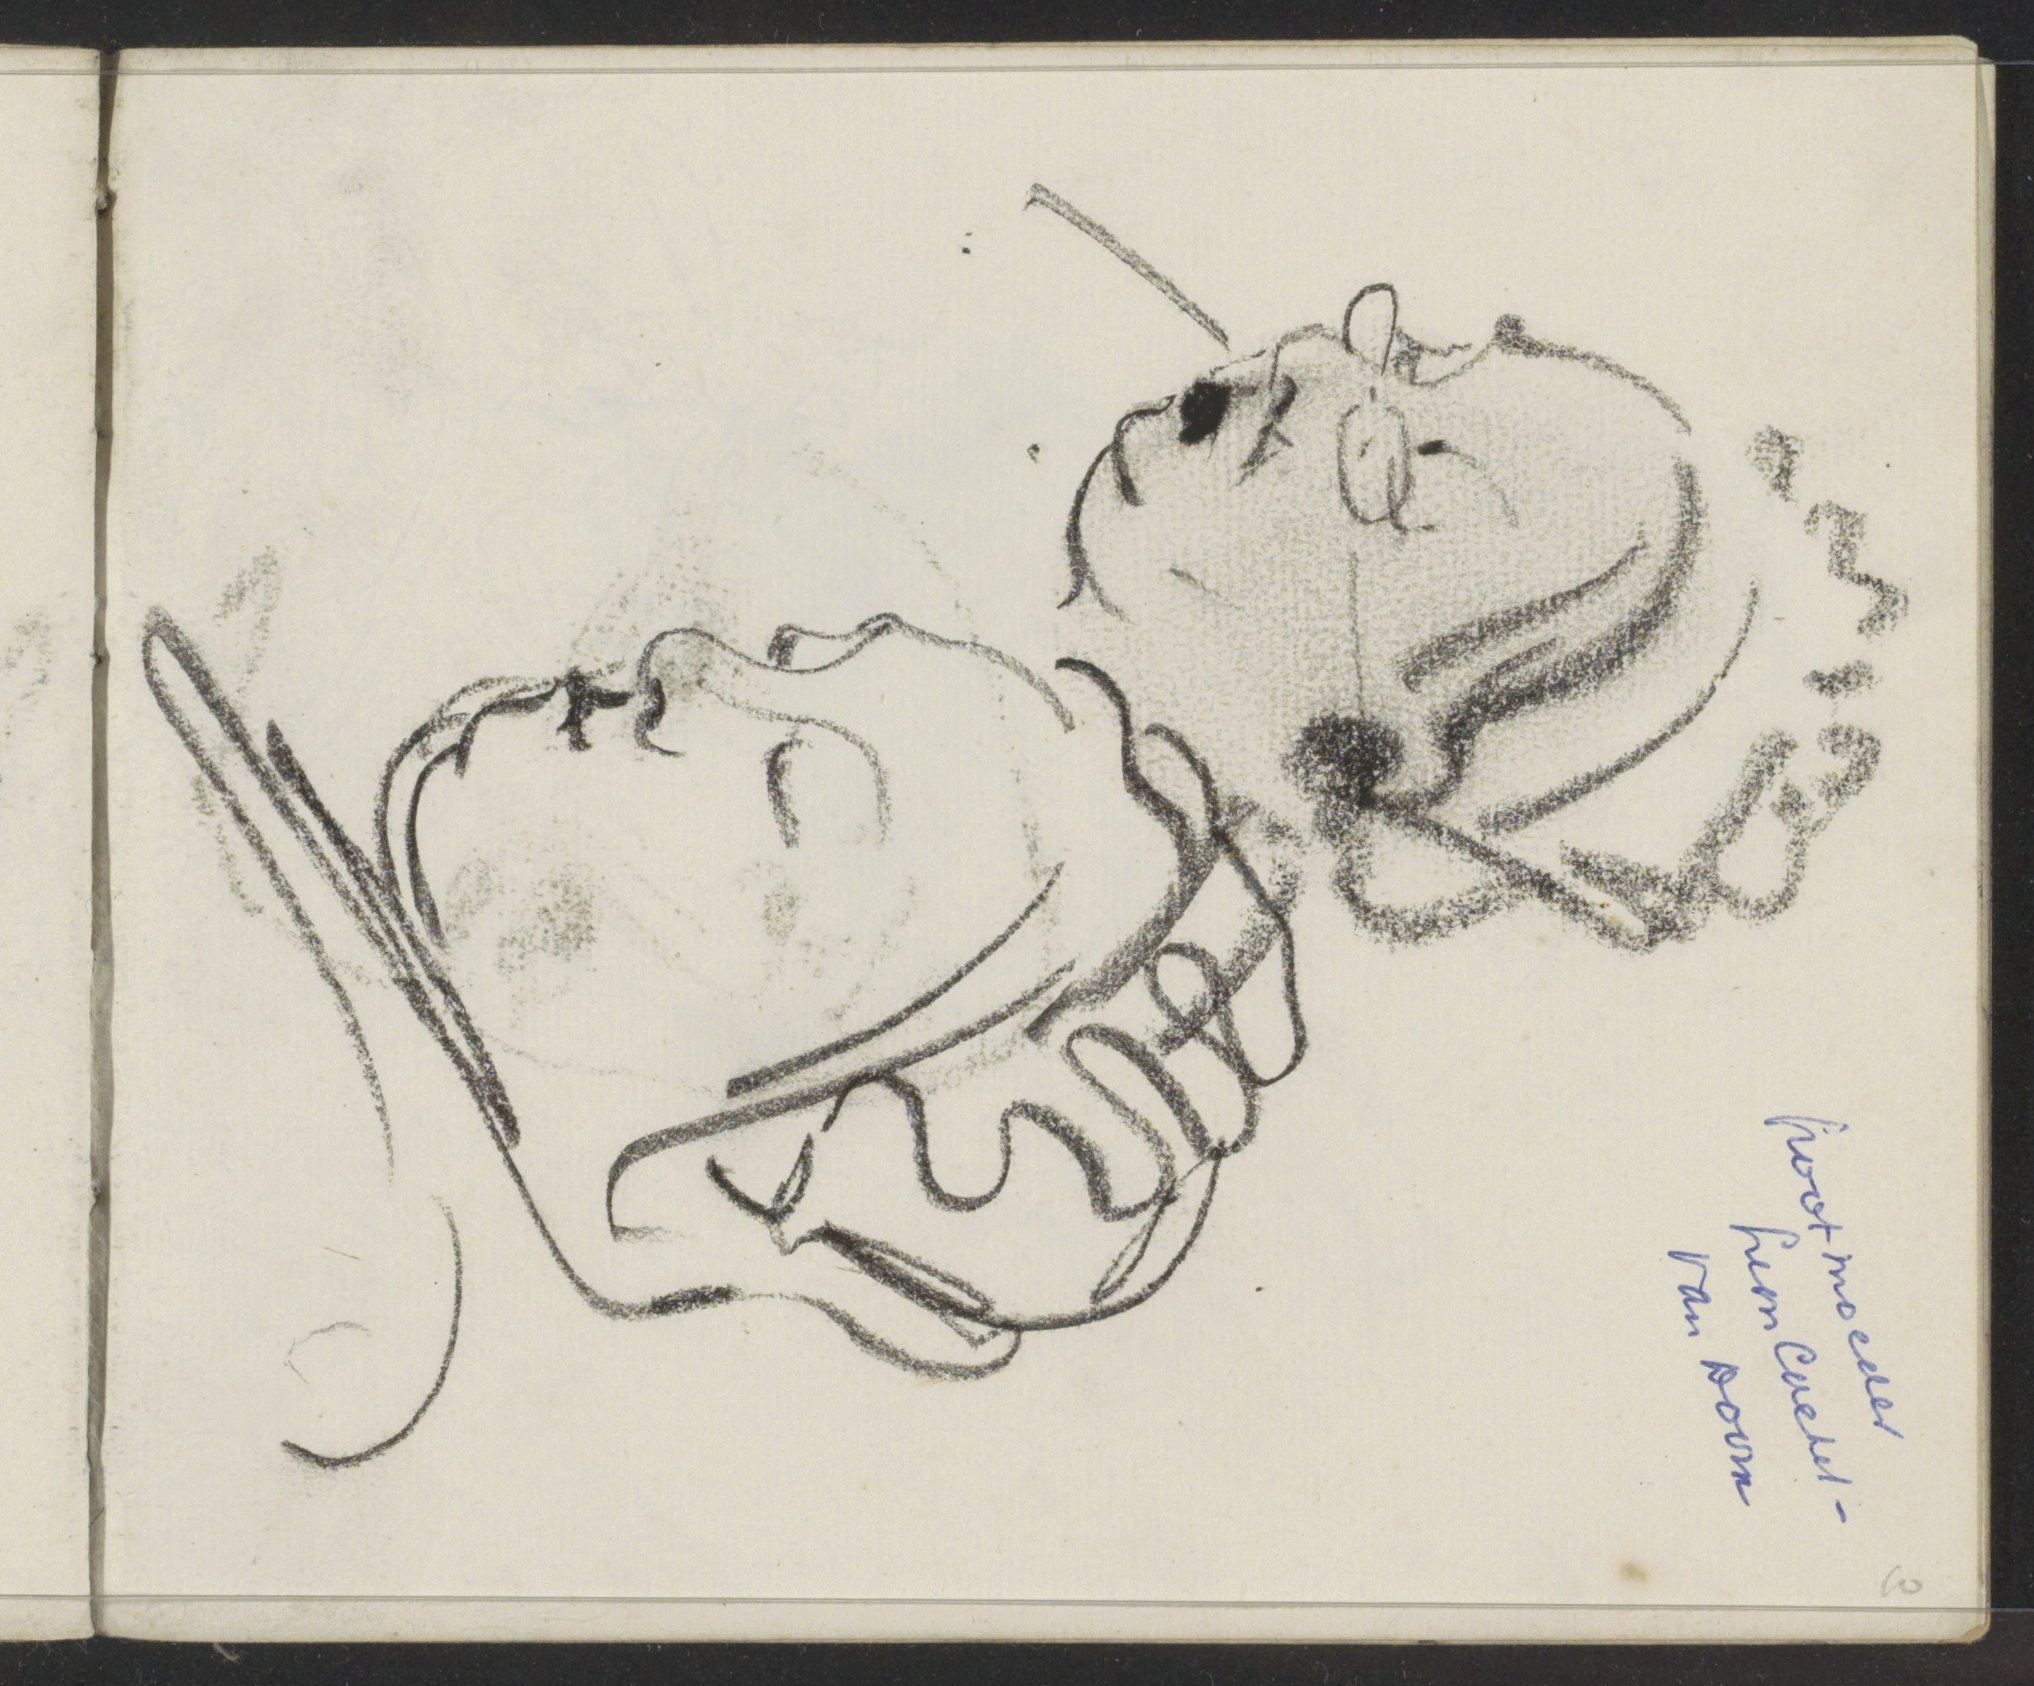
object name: sketchbook leaf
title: Kop van een oudere vrouw met een muts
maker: carel adolph lion cachet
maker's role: draughtsman, print maker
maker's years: 1864-1945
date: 1895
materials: chalk, paper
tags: head (human) (+ old female (human being))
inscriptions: annotation: ‘grootmoeder/ Lion Cachet-/ van Doorn’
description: Blad 10 recto uit een schetsboek met 11 bladen.